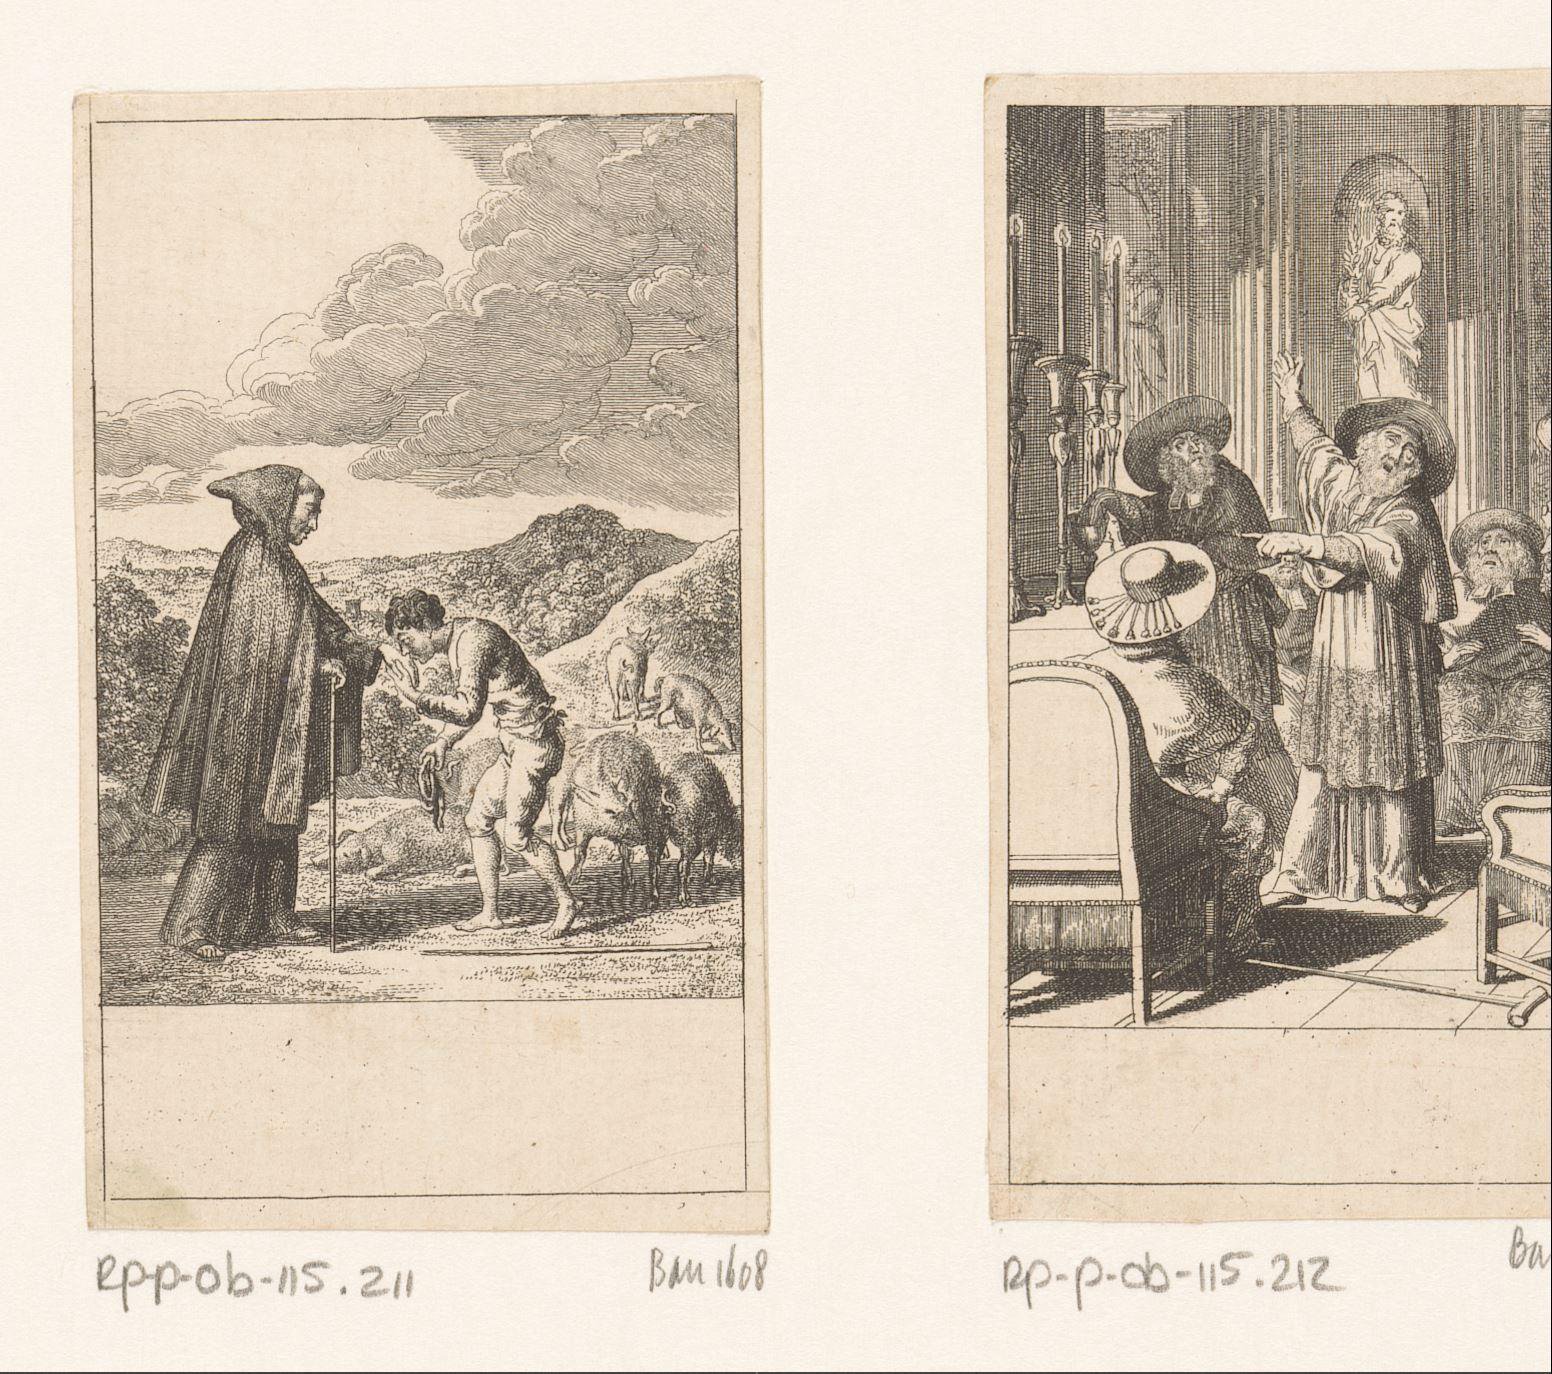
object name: print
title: Felix Perrettis buigt voor de franciscaner monnik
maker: daniel nikolaus chodowiecki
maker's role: draughtsman, print maker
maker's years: 1726-1801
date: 1792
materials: paper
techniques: etching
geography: berlin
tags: rome, sixtus v, boar (male pig), history, head bent forward; bowing, monastic orders, monastic life: franciscans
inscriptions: collector's mark: Lugt 2228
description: Latere staat gebruikt voor: Almanac de Gotha pour l'anneé 1793. Gotha: C. W. Ettinger, [1792].